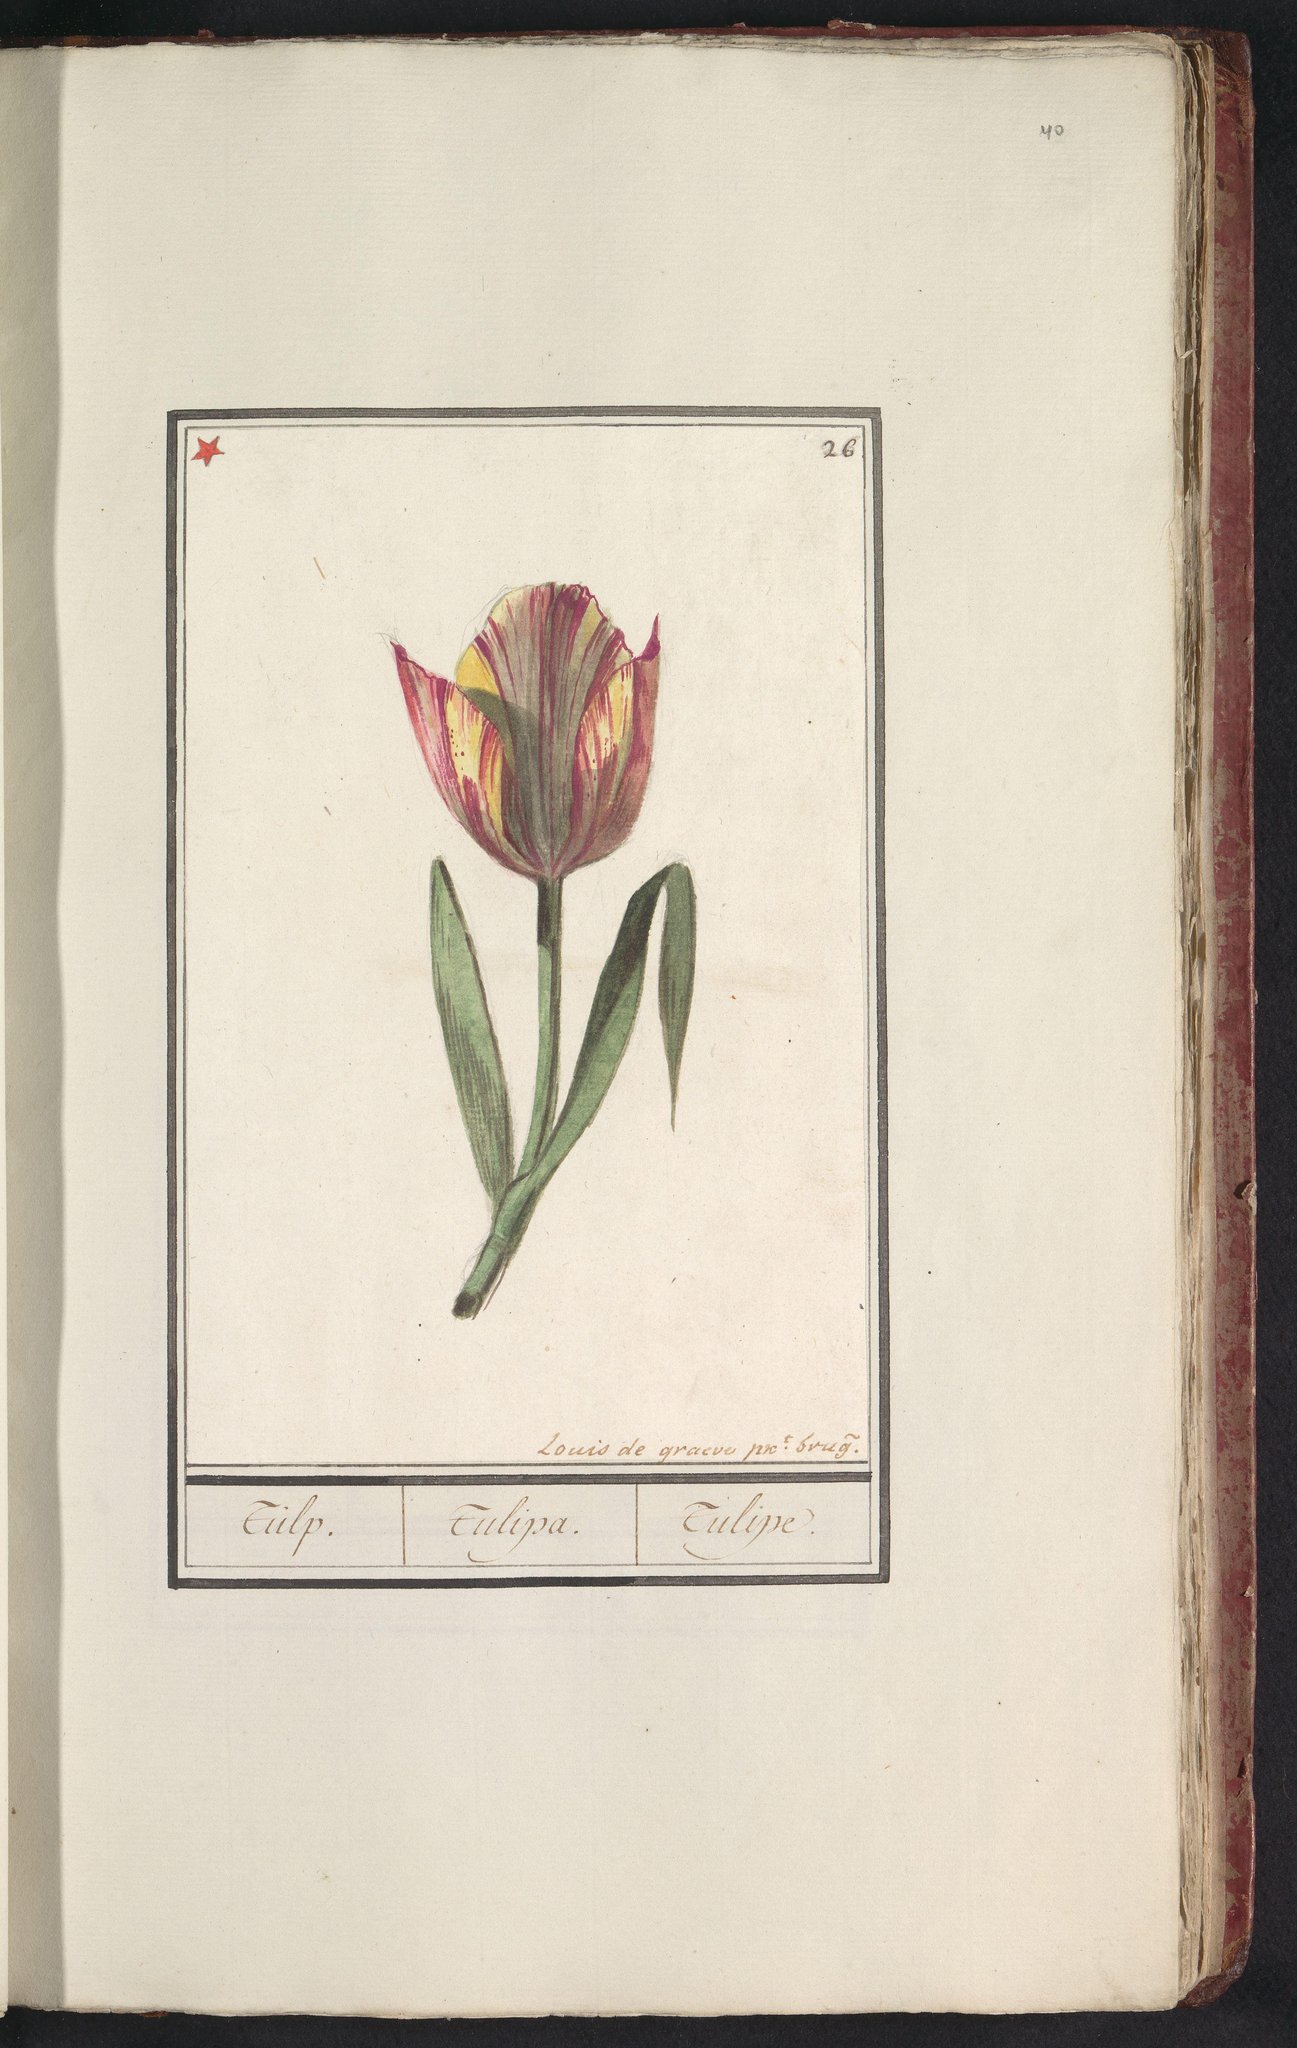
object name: drawing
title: Tulp (Tulipa)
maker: louis de graeve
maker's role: draughtsman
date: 1790-1814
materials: paint, paper, pencil, watercolor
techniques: brush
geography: bruges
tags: flowers: tulip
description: Rood-gele tulp. Genummerd rechtsboven: 26. Linksboven gemerkt met een rood sterretje. Onderdeel van het eerste album met tekeningen van bloemen en planten. Achtste van twaalf albums met tekeningen van dieren, vogels en planten bekend rond 1600, gemaakt in opdracht van keizer Rudolf II. Met toelichting in Nederlands, Latijn en Frans.